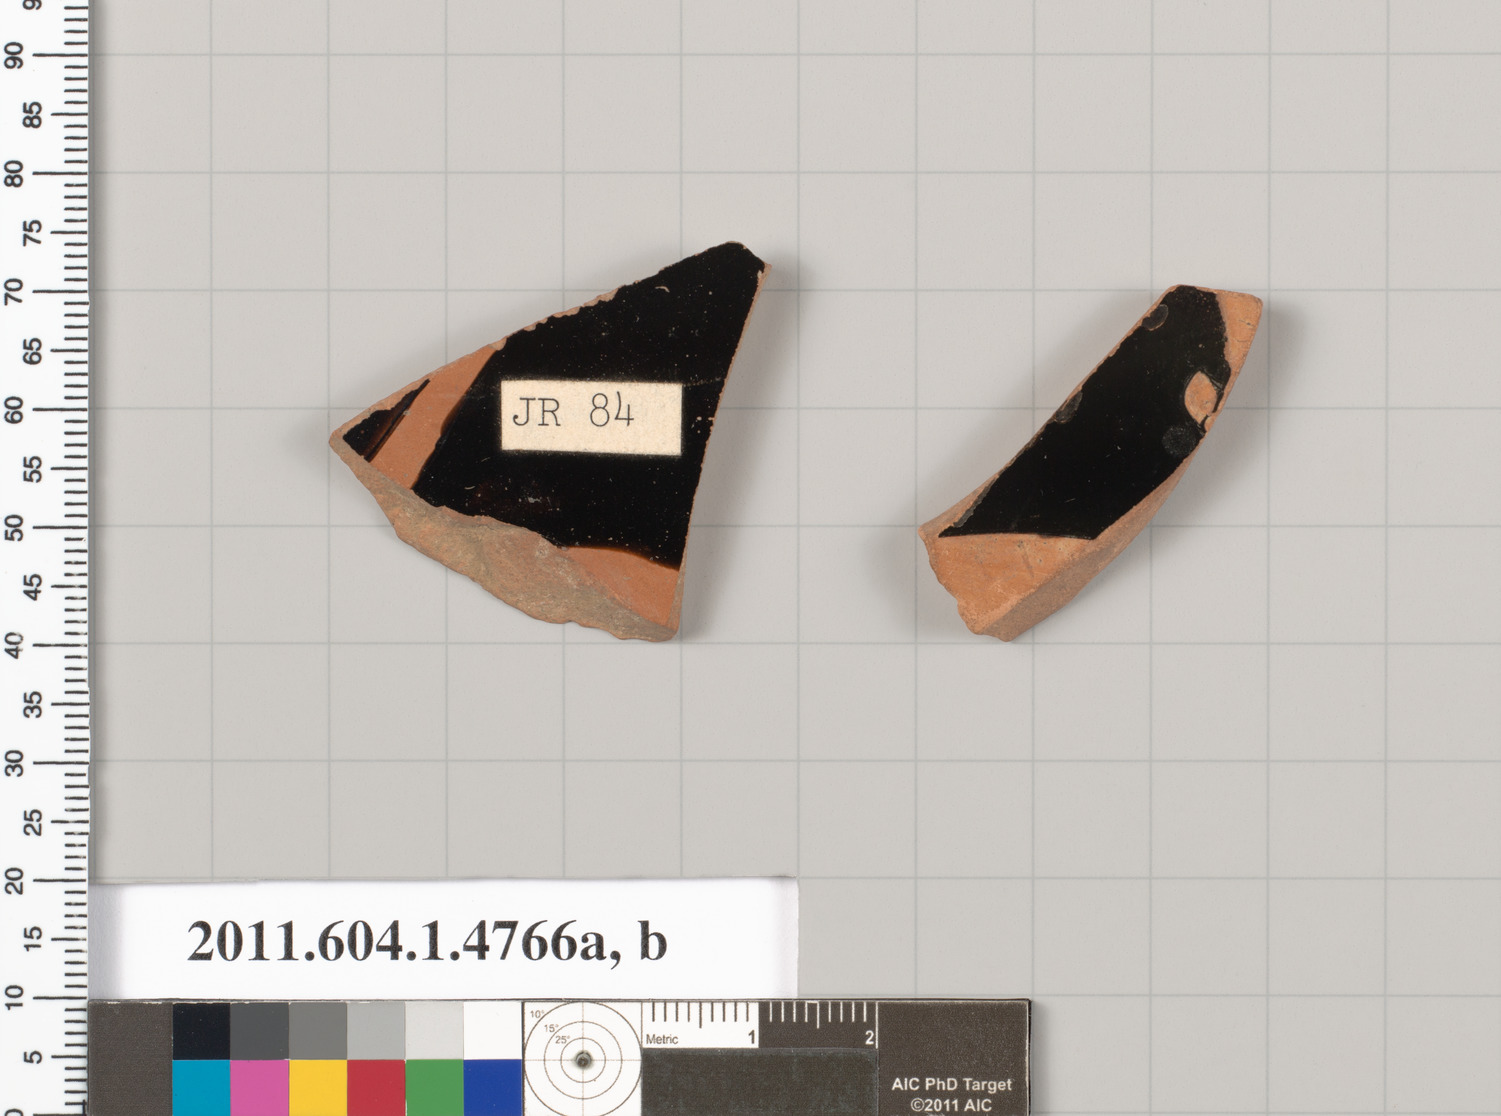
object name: kylix fragment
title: Terracotta fragments of kylikes (drinking cups)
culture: greek, attic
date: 475-451 BCE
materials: terracotta